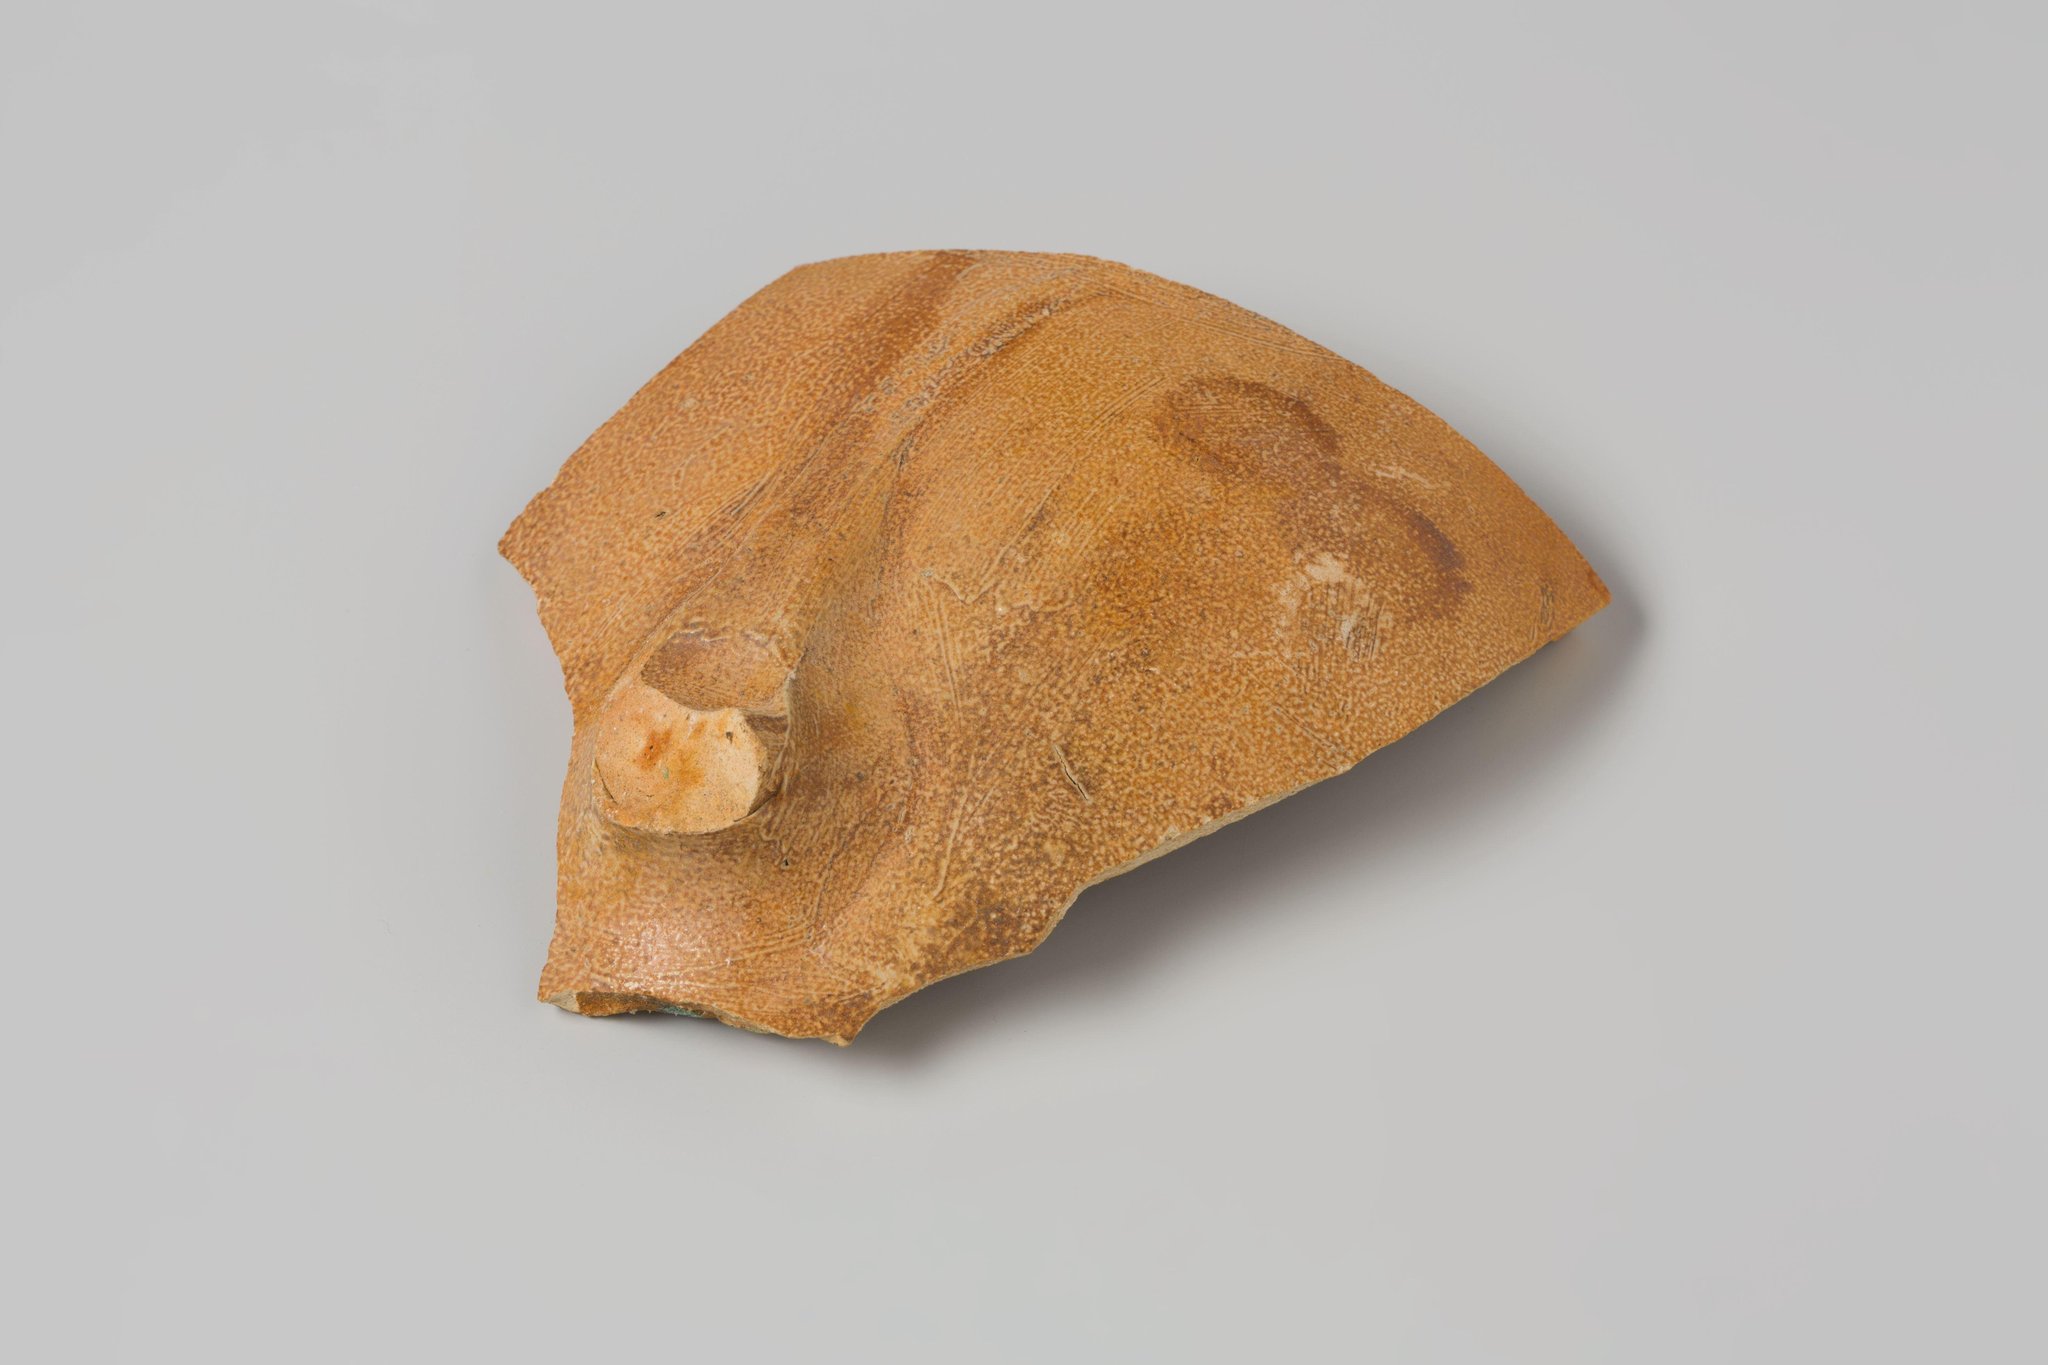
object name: ewer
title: Scherf van een kan uit het wrak van de Oost-Indiëvaarder Hollandia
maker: Anonymous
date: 1700-1743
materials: stoneware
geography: cologne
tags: verenigde oostindische compagnie, hollandia (schip), annet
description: Stoneware, Rhenish, Frechen-ware, jug; fragm of shoulder with lower join of handle, broken, relieved spike-shaped.